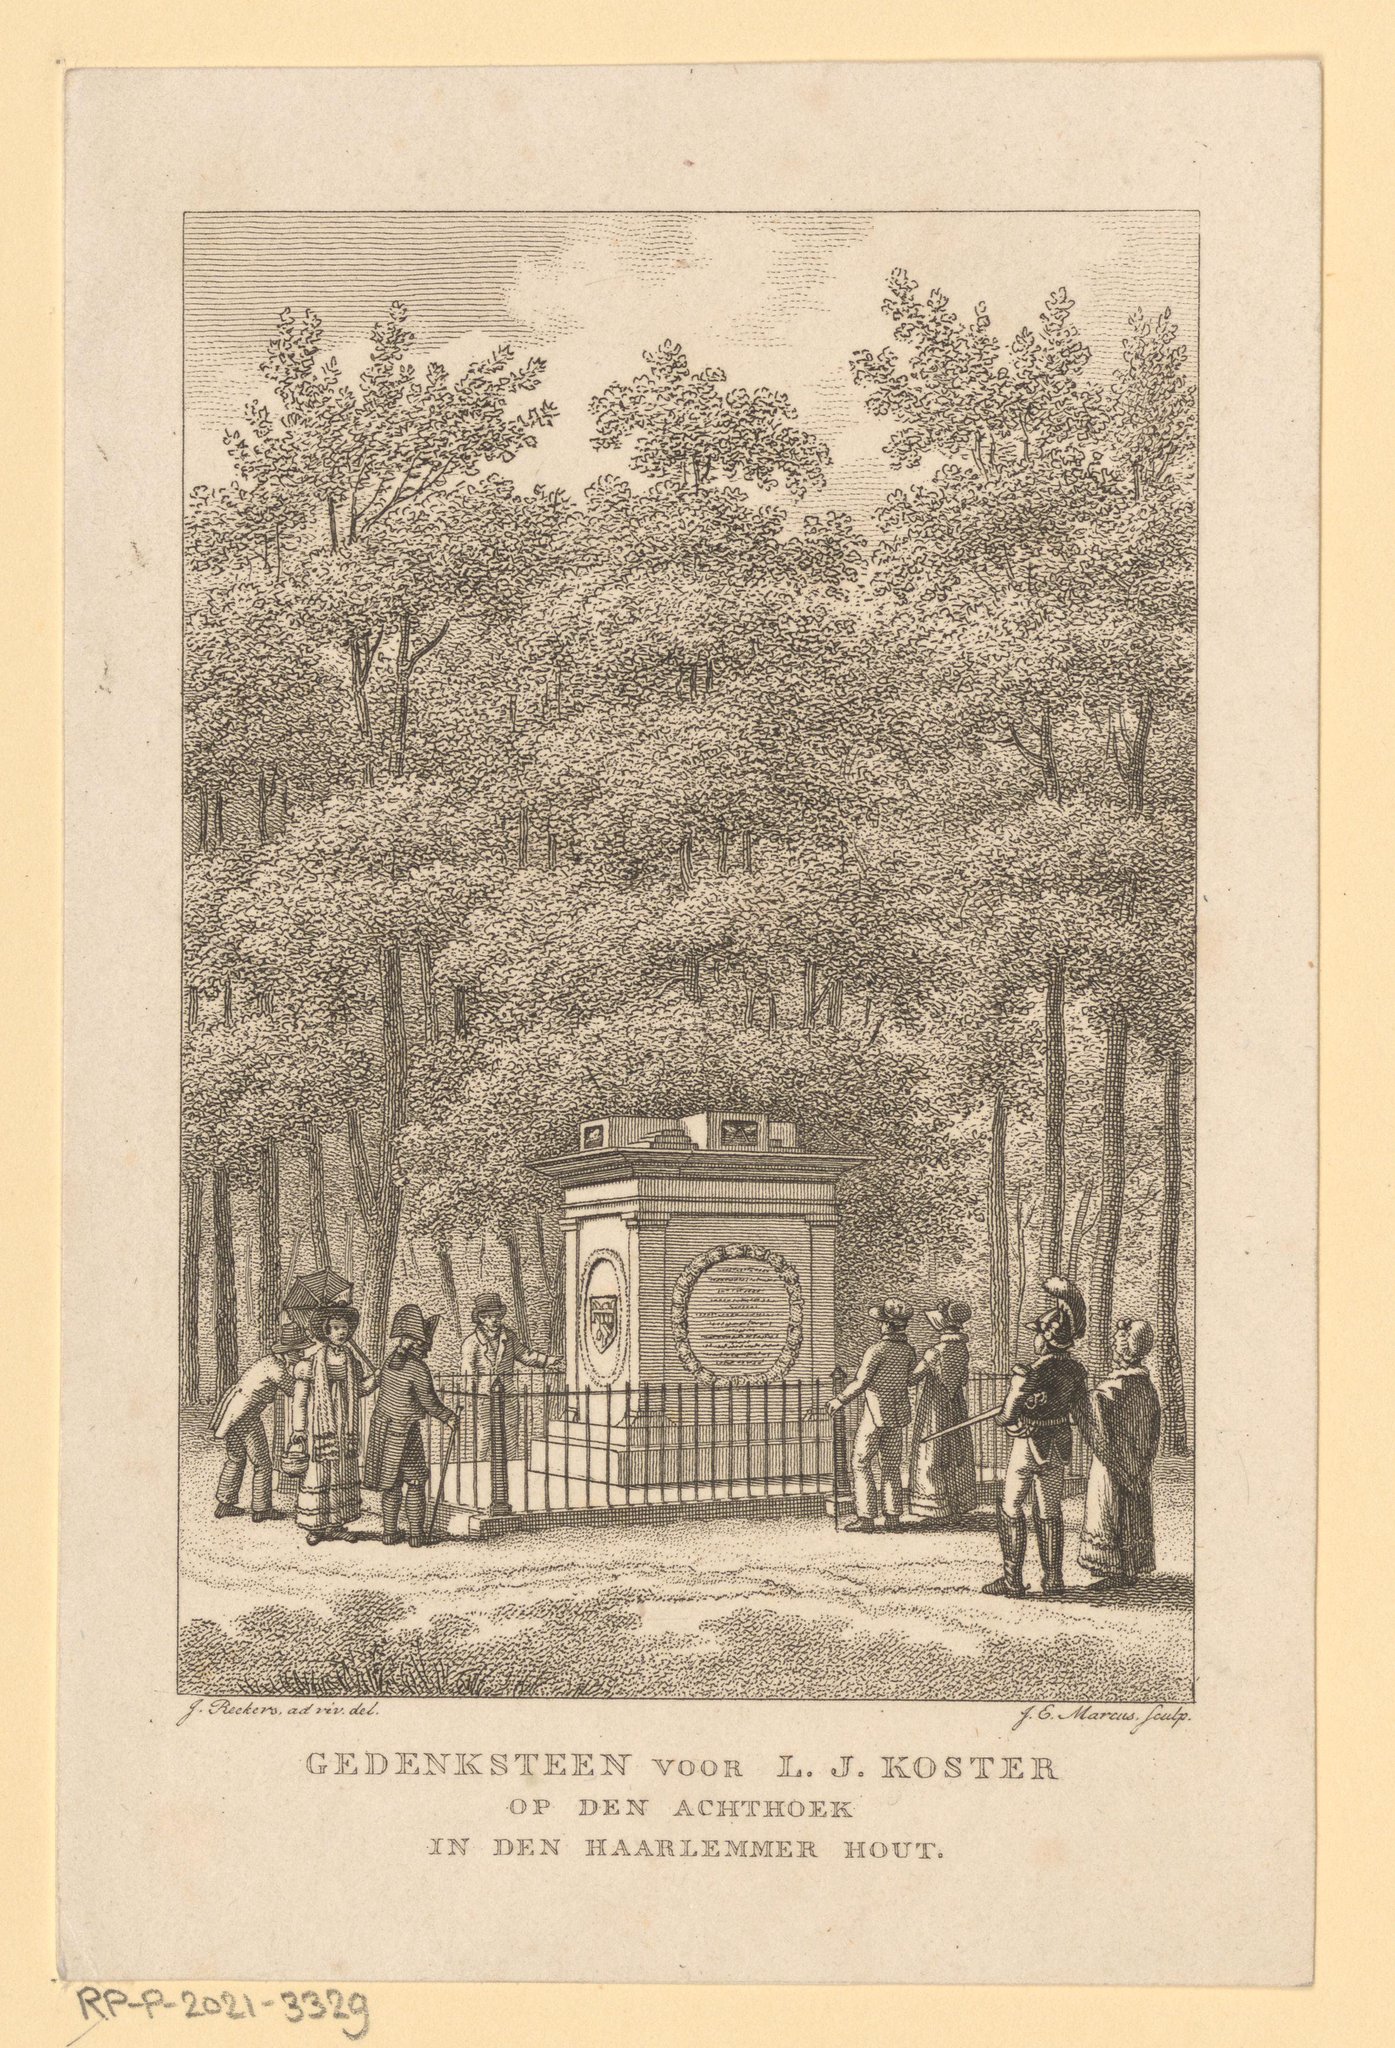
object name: print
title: Gedenksteen voor Coster bij 400-jarig jubileum uitvinding boekdrukkunst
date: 1824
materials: paper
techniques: engraving, etching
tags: haarlem, park, grave, tomb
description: Monument voor Coster opgericht in de Haarlemmerhout bij de viering van het 400-jarige jubileum op 10-11 juli in 1823 van de uitvinding boekdrukkunst door Laurens Jansz. Coster te Haarlem in 1423.